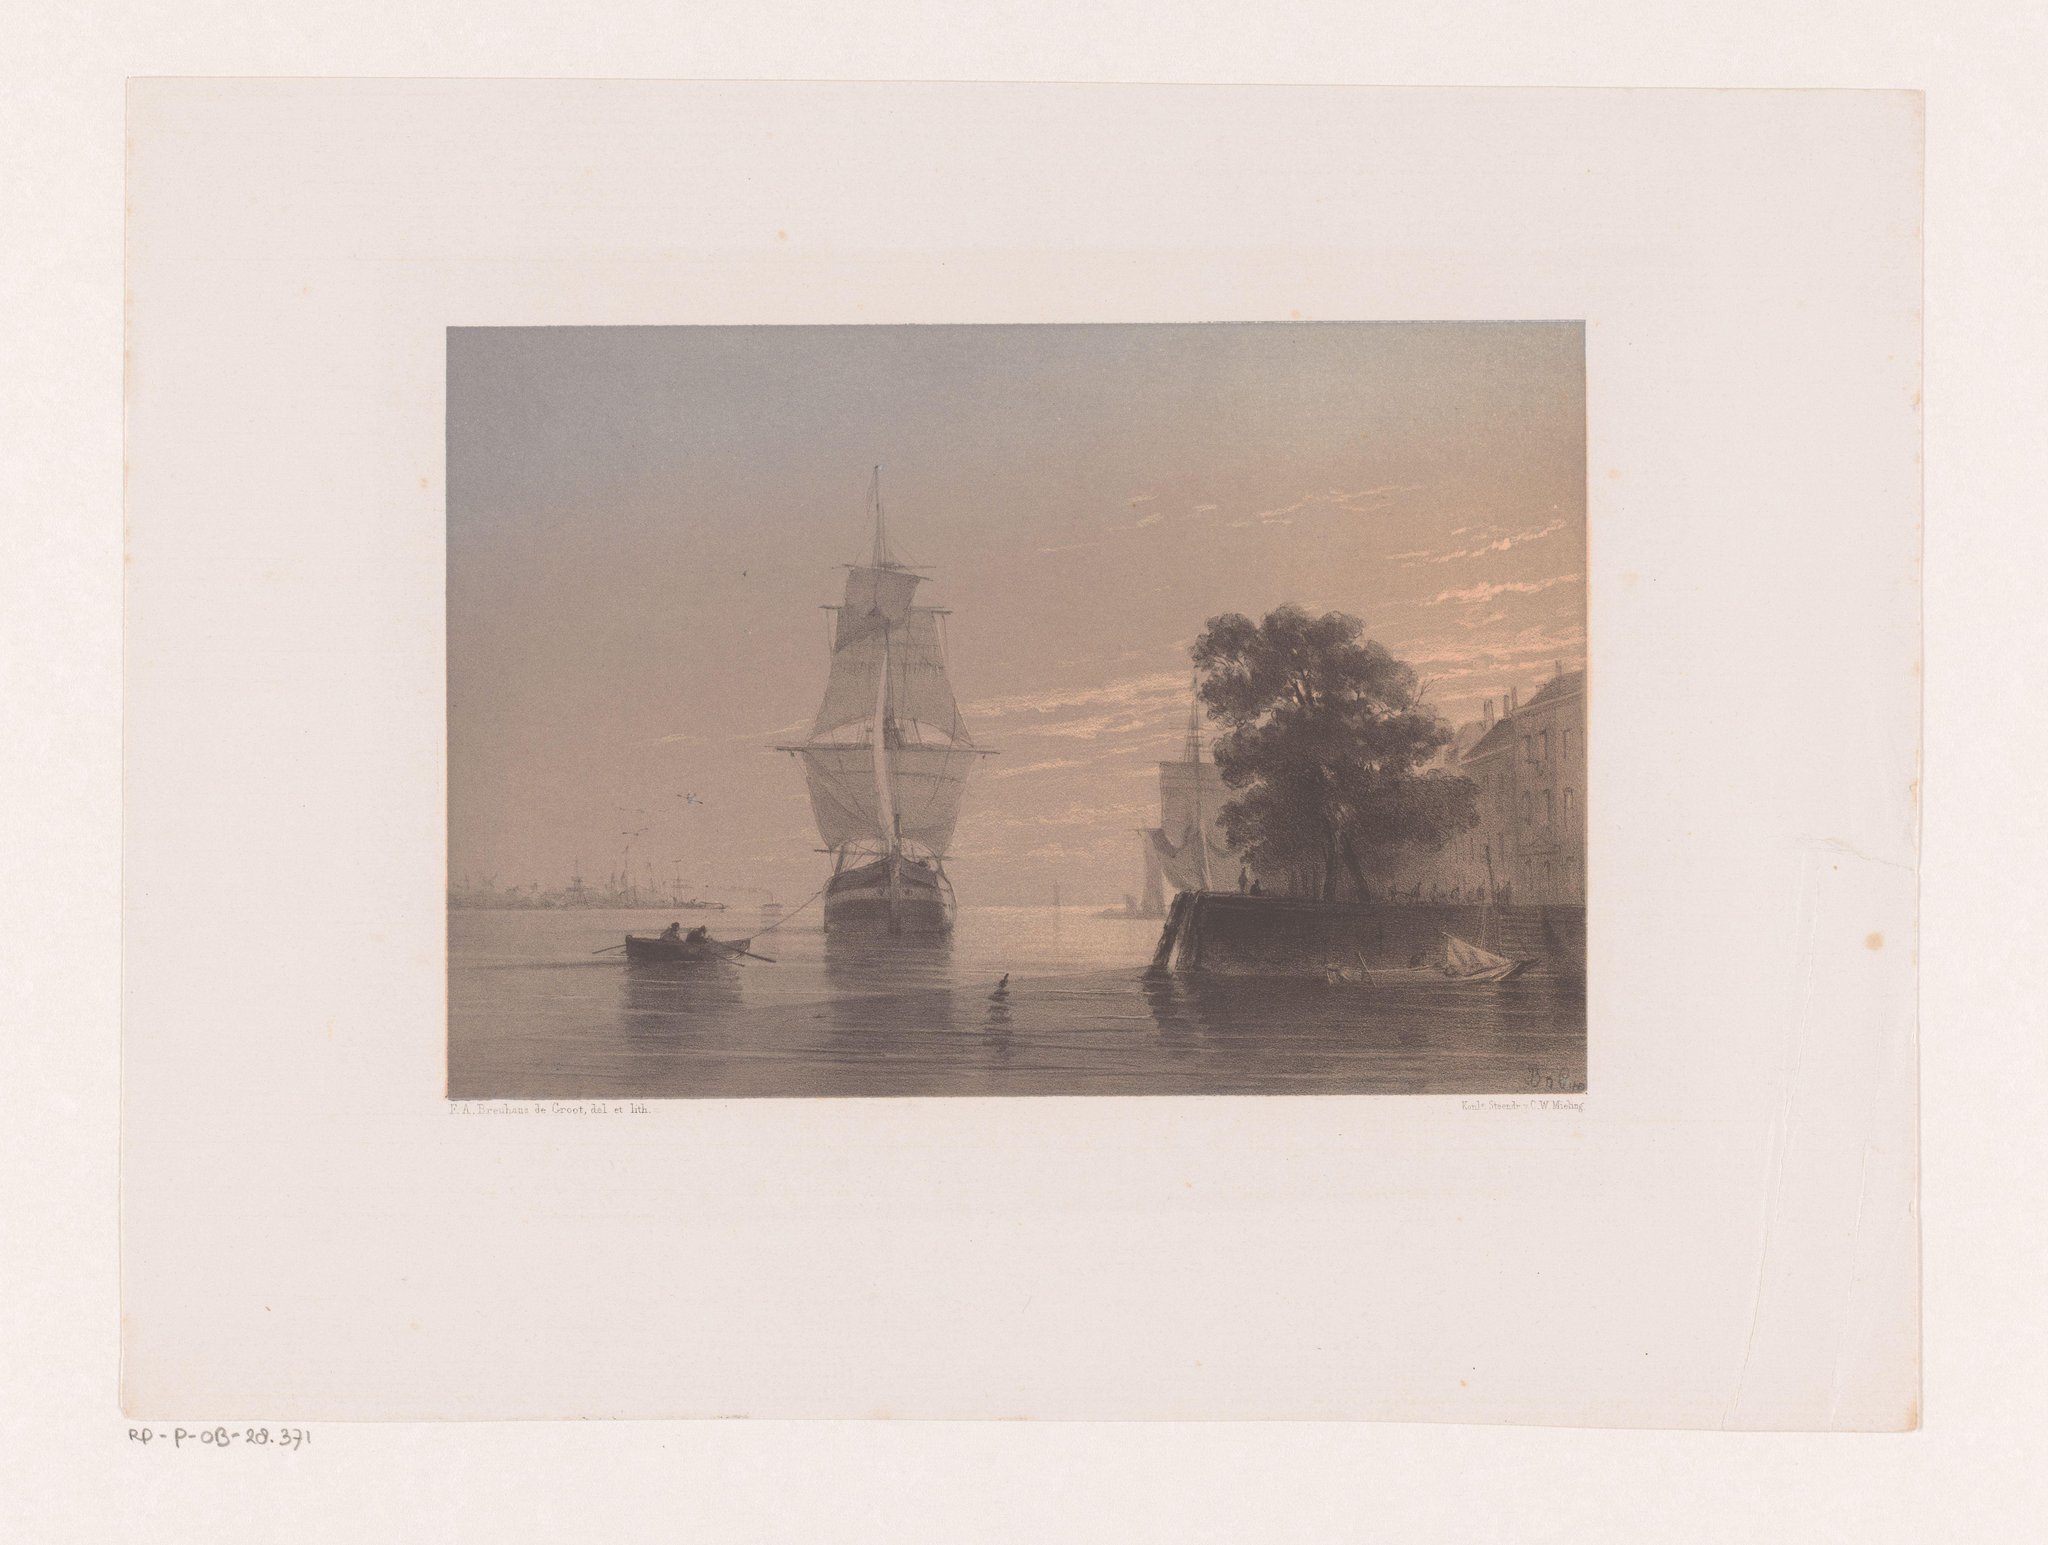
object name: print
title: Zeilschepen bij een kade bij ondergaande zon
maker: frans arnold breuhaus de groot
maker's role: draughtsman, print maker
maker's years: 1824-1872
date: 1847-1863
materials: paper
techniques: tone lithography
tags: sailing-ship, sailing-boat, rowing-boat, canoe, etc., sunset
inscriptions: collector's mark: Lugt 2228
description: De schepen liggen met gestreken zeilen voor anker. Links vaart een roeiboot.